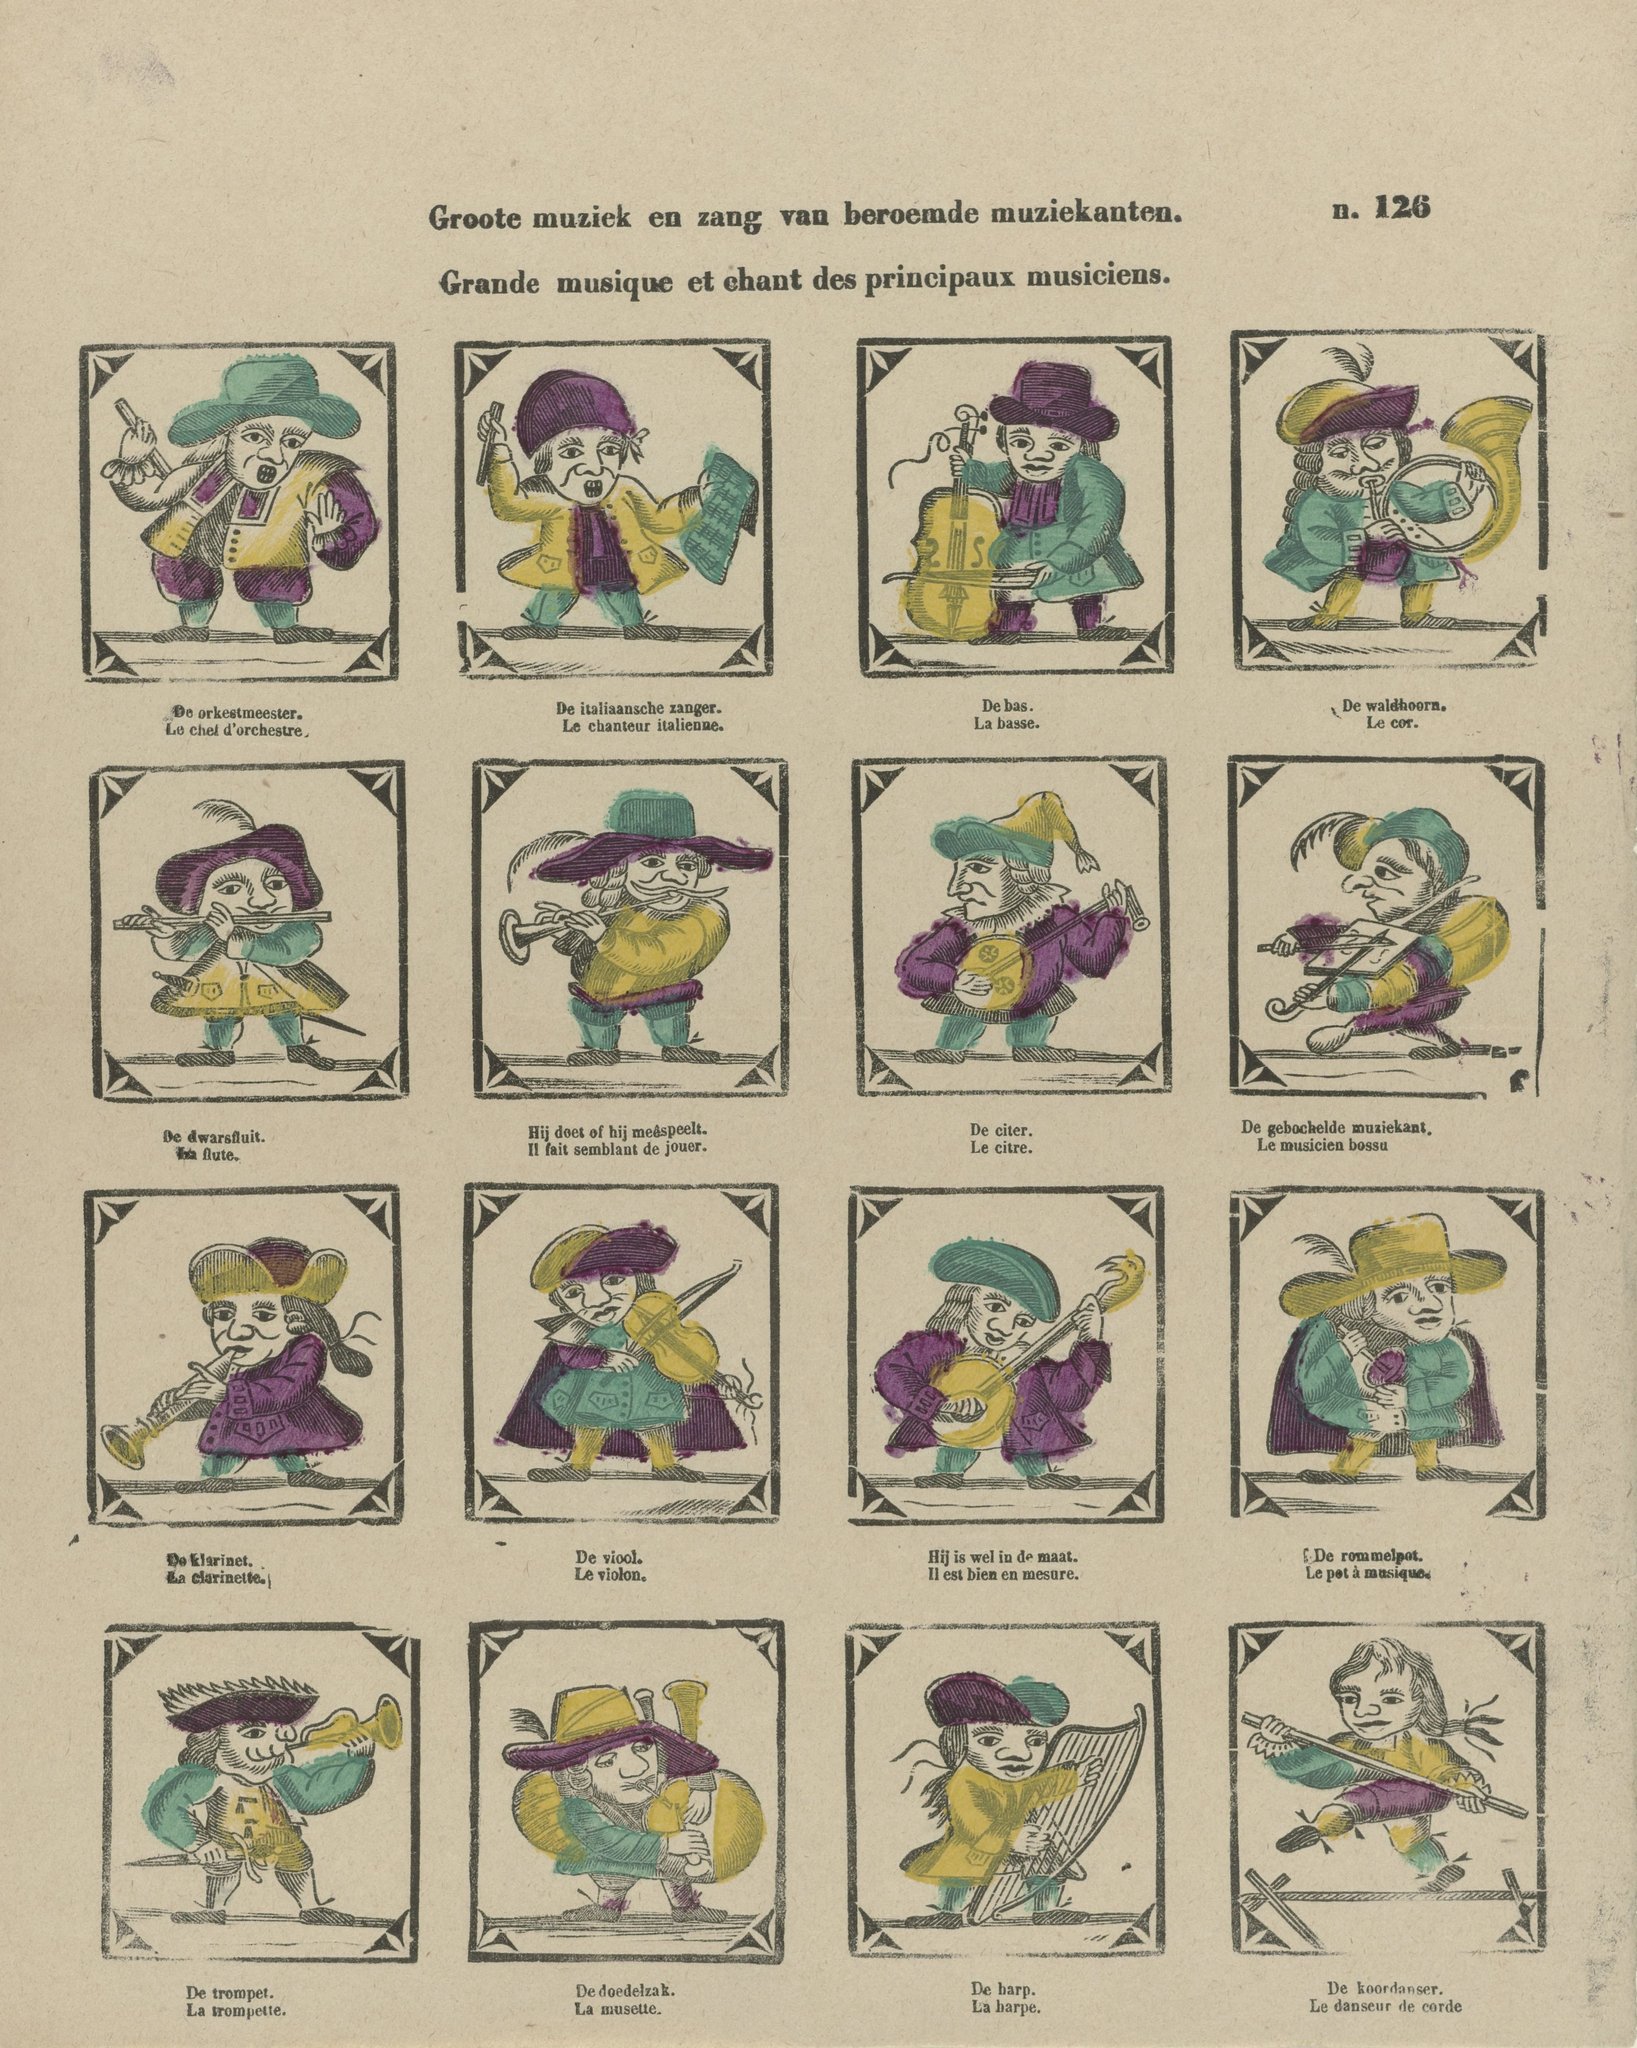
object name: popular print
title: Groote muziek en zang van beroemde muziekanten / Grande musique et chant des principaux musiciens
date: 1800-1833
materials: paper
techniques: colour, letterpress printing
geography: turnhout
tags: musician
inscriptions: collector's mark: Lugt 2760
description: Blad met 16 voorstellingen van muzikanten. Onder elke afbeelding een onderschrift in het Nederlands en in het Frans. Genummerd midden boven: n. 126.